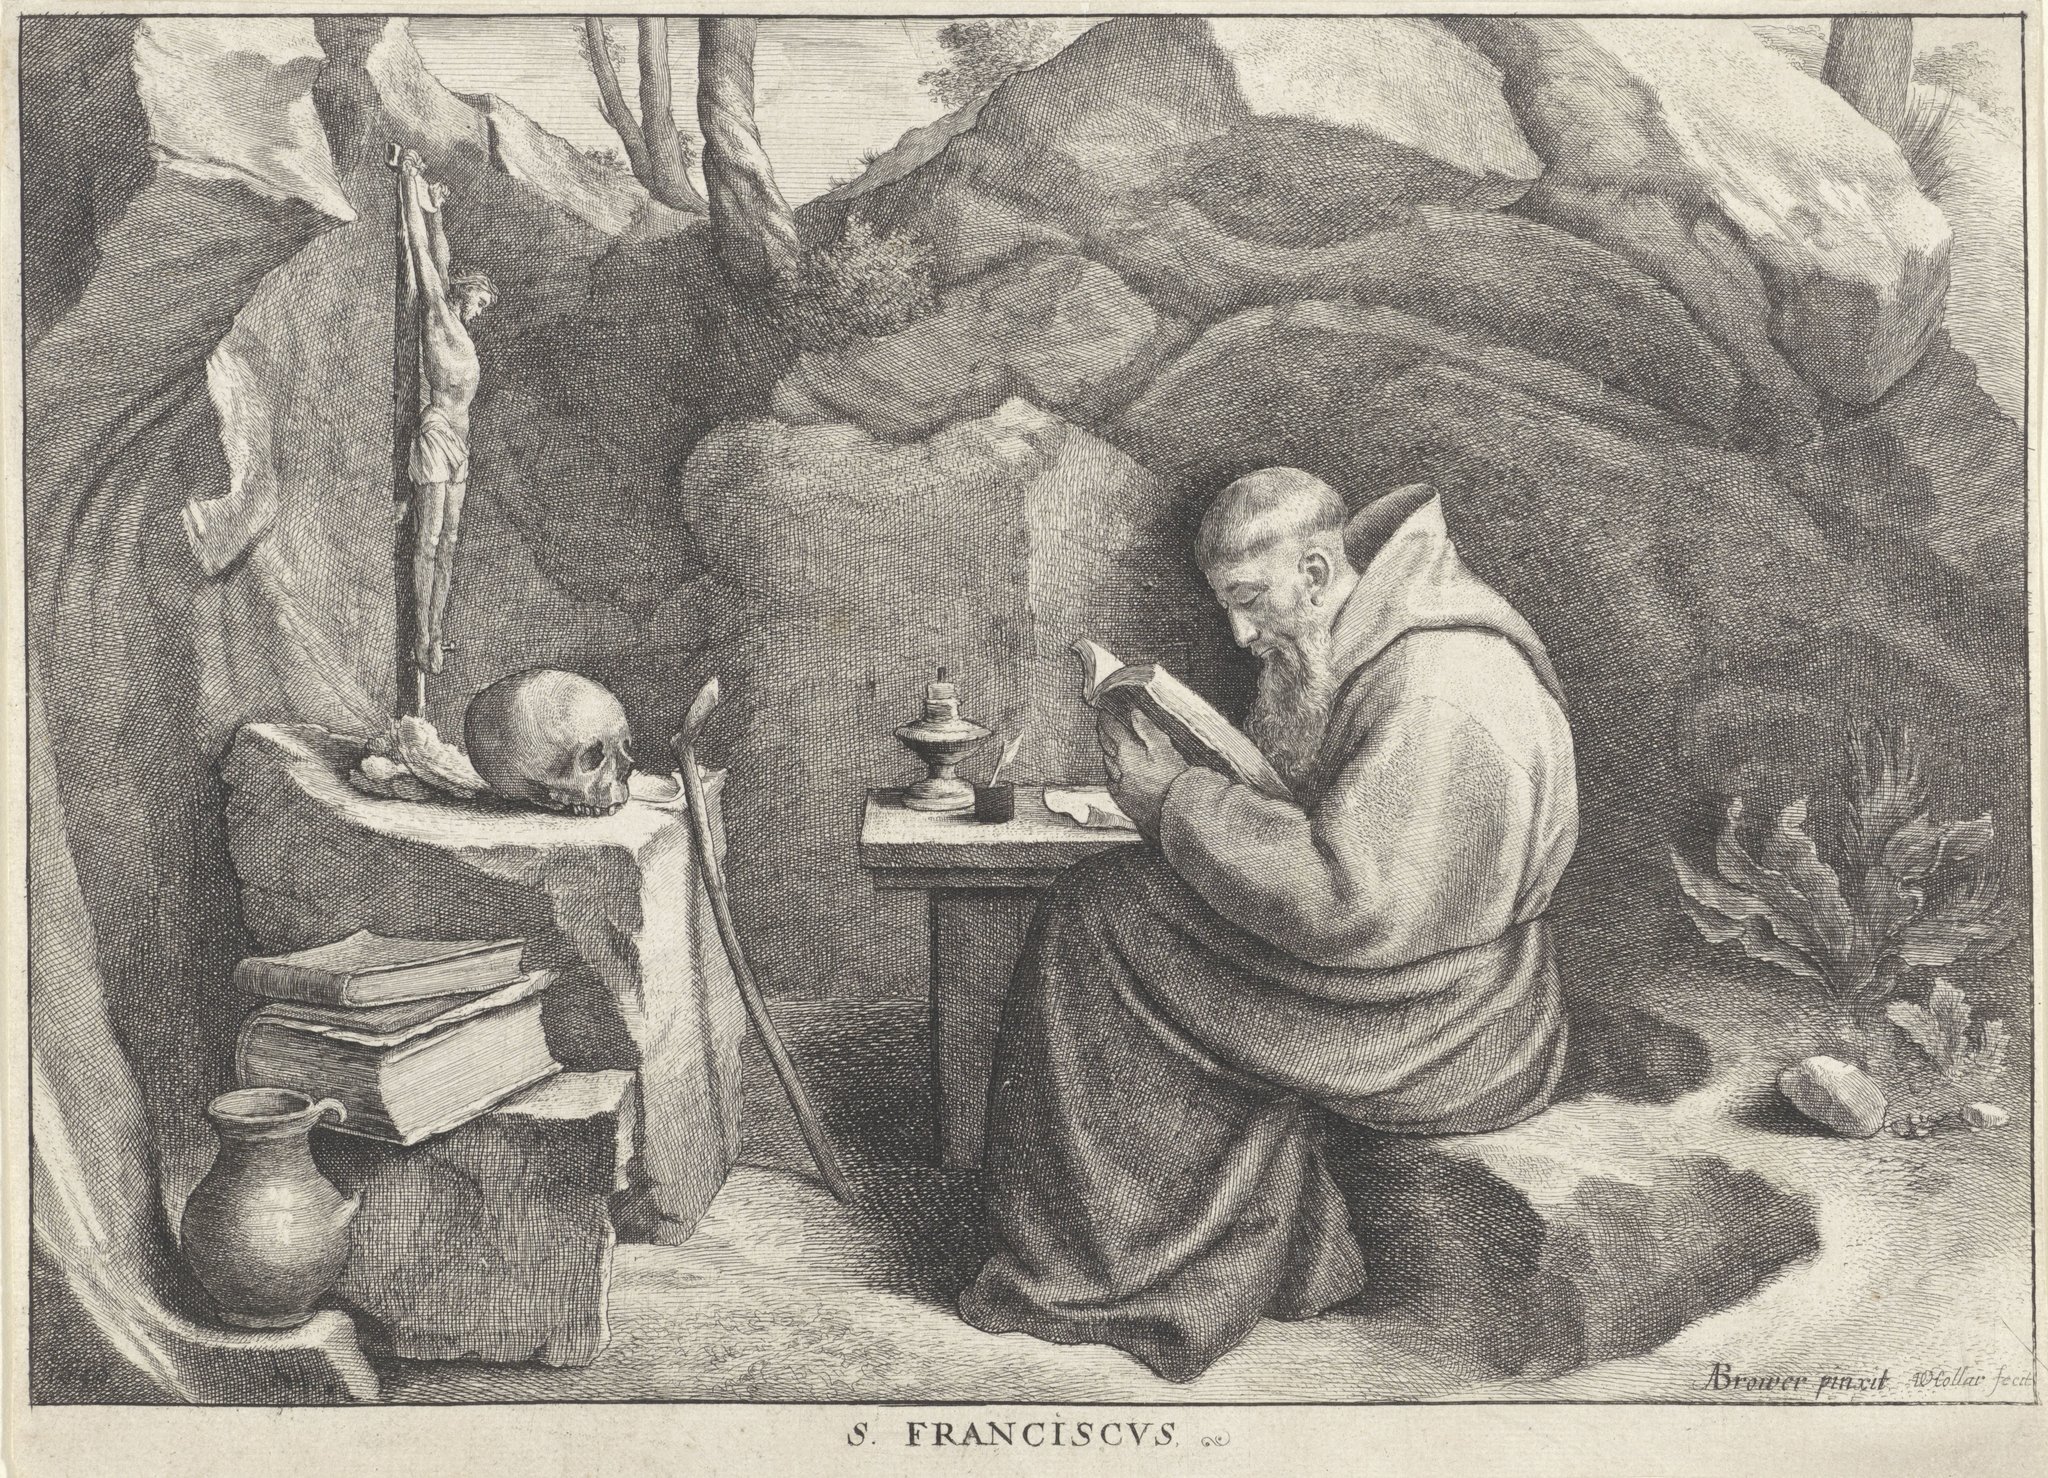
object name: print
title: S. Franciscus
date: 1644-1652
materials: paper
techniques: etching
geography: antwerp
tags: personal devotion of st. francis of assisi - penitence of male saint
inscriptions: collector's mark: Lugt 1383, collector's mark: Lugt 654